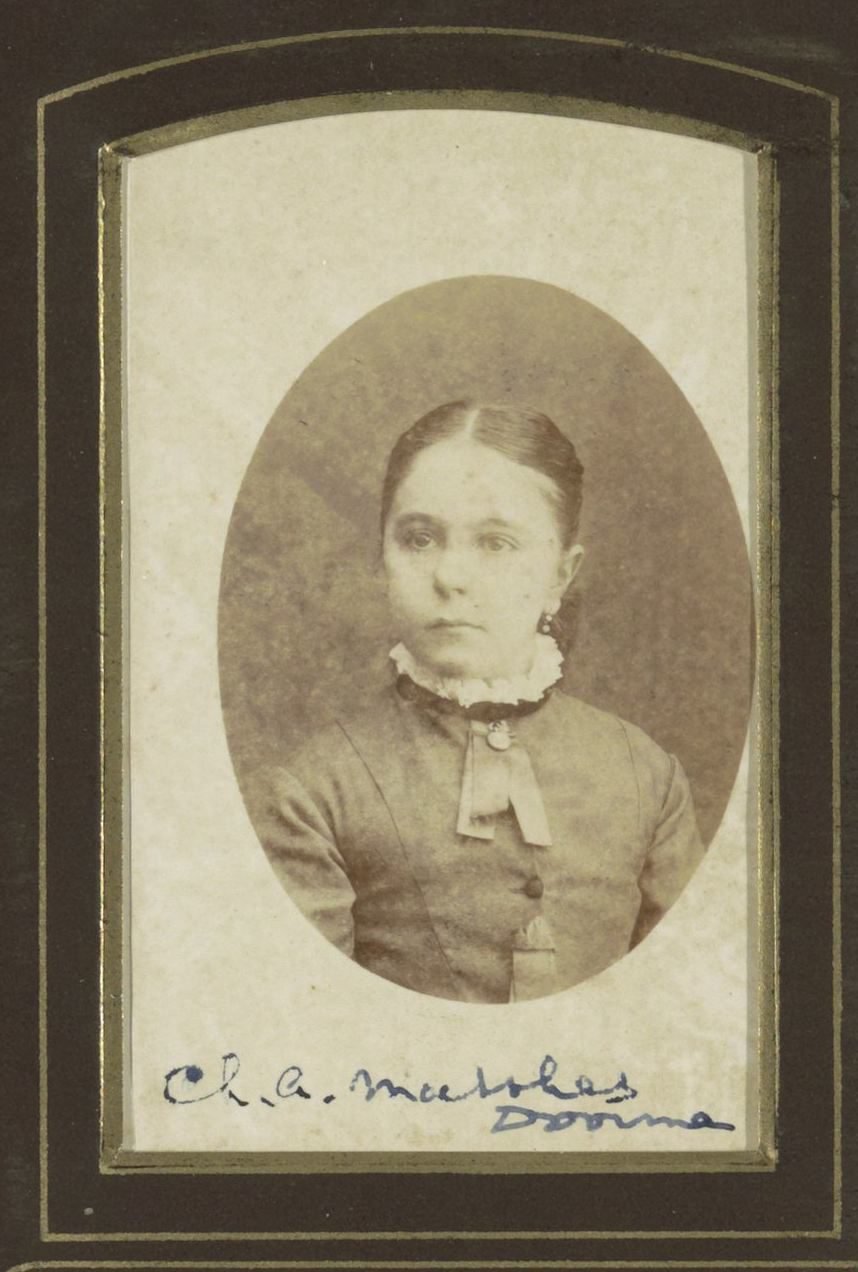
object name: album leaf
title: Portret van Ch.A. Matthes-Doorman als kind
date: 1864-1890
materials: cardboard, paper, photographic support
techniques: albumen print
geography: netherlands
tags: historical persons - bb - woman, child, netherlands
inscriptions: address: ‘Amsterdam Rokin over de Bank 138 Utrecht Hamburgerstraat F. 237’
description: Onderdeel van Fotoalbum van de families Matthes, Doorman en Van Thiel.